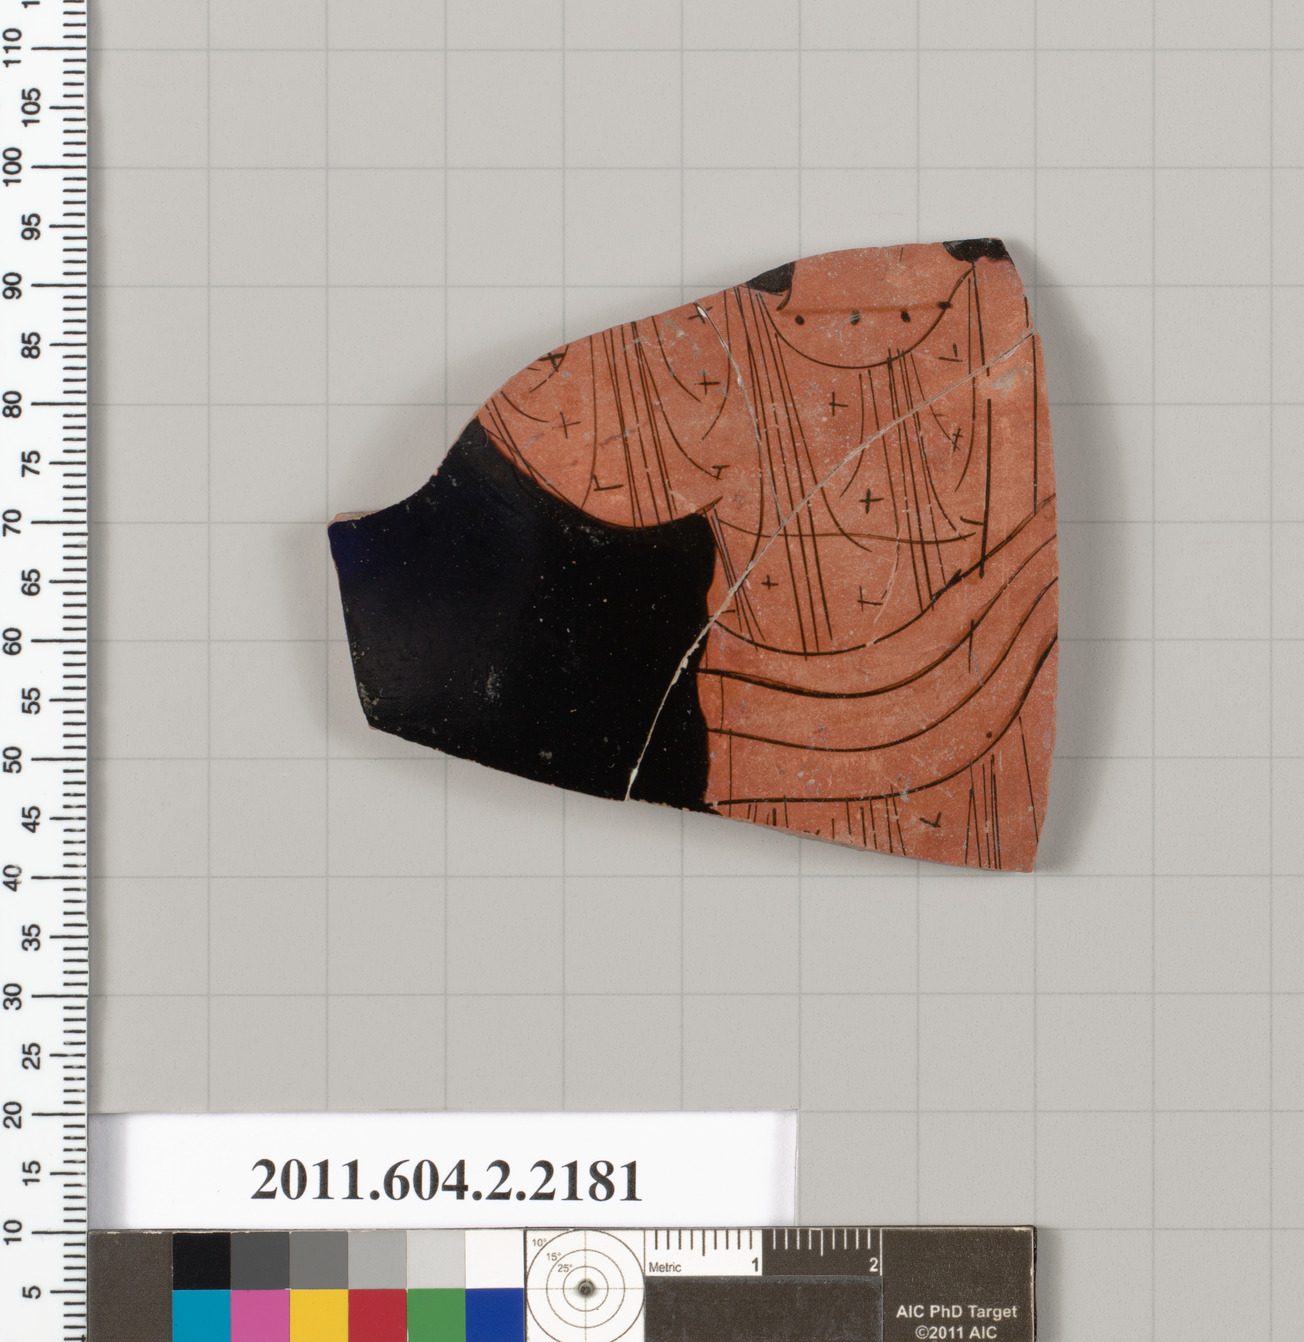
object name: pot fragment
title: Terracotta fragment of a pot; unglazed on the inside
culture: greek, attic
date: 475-451 BCE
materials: terracotta